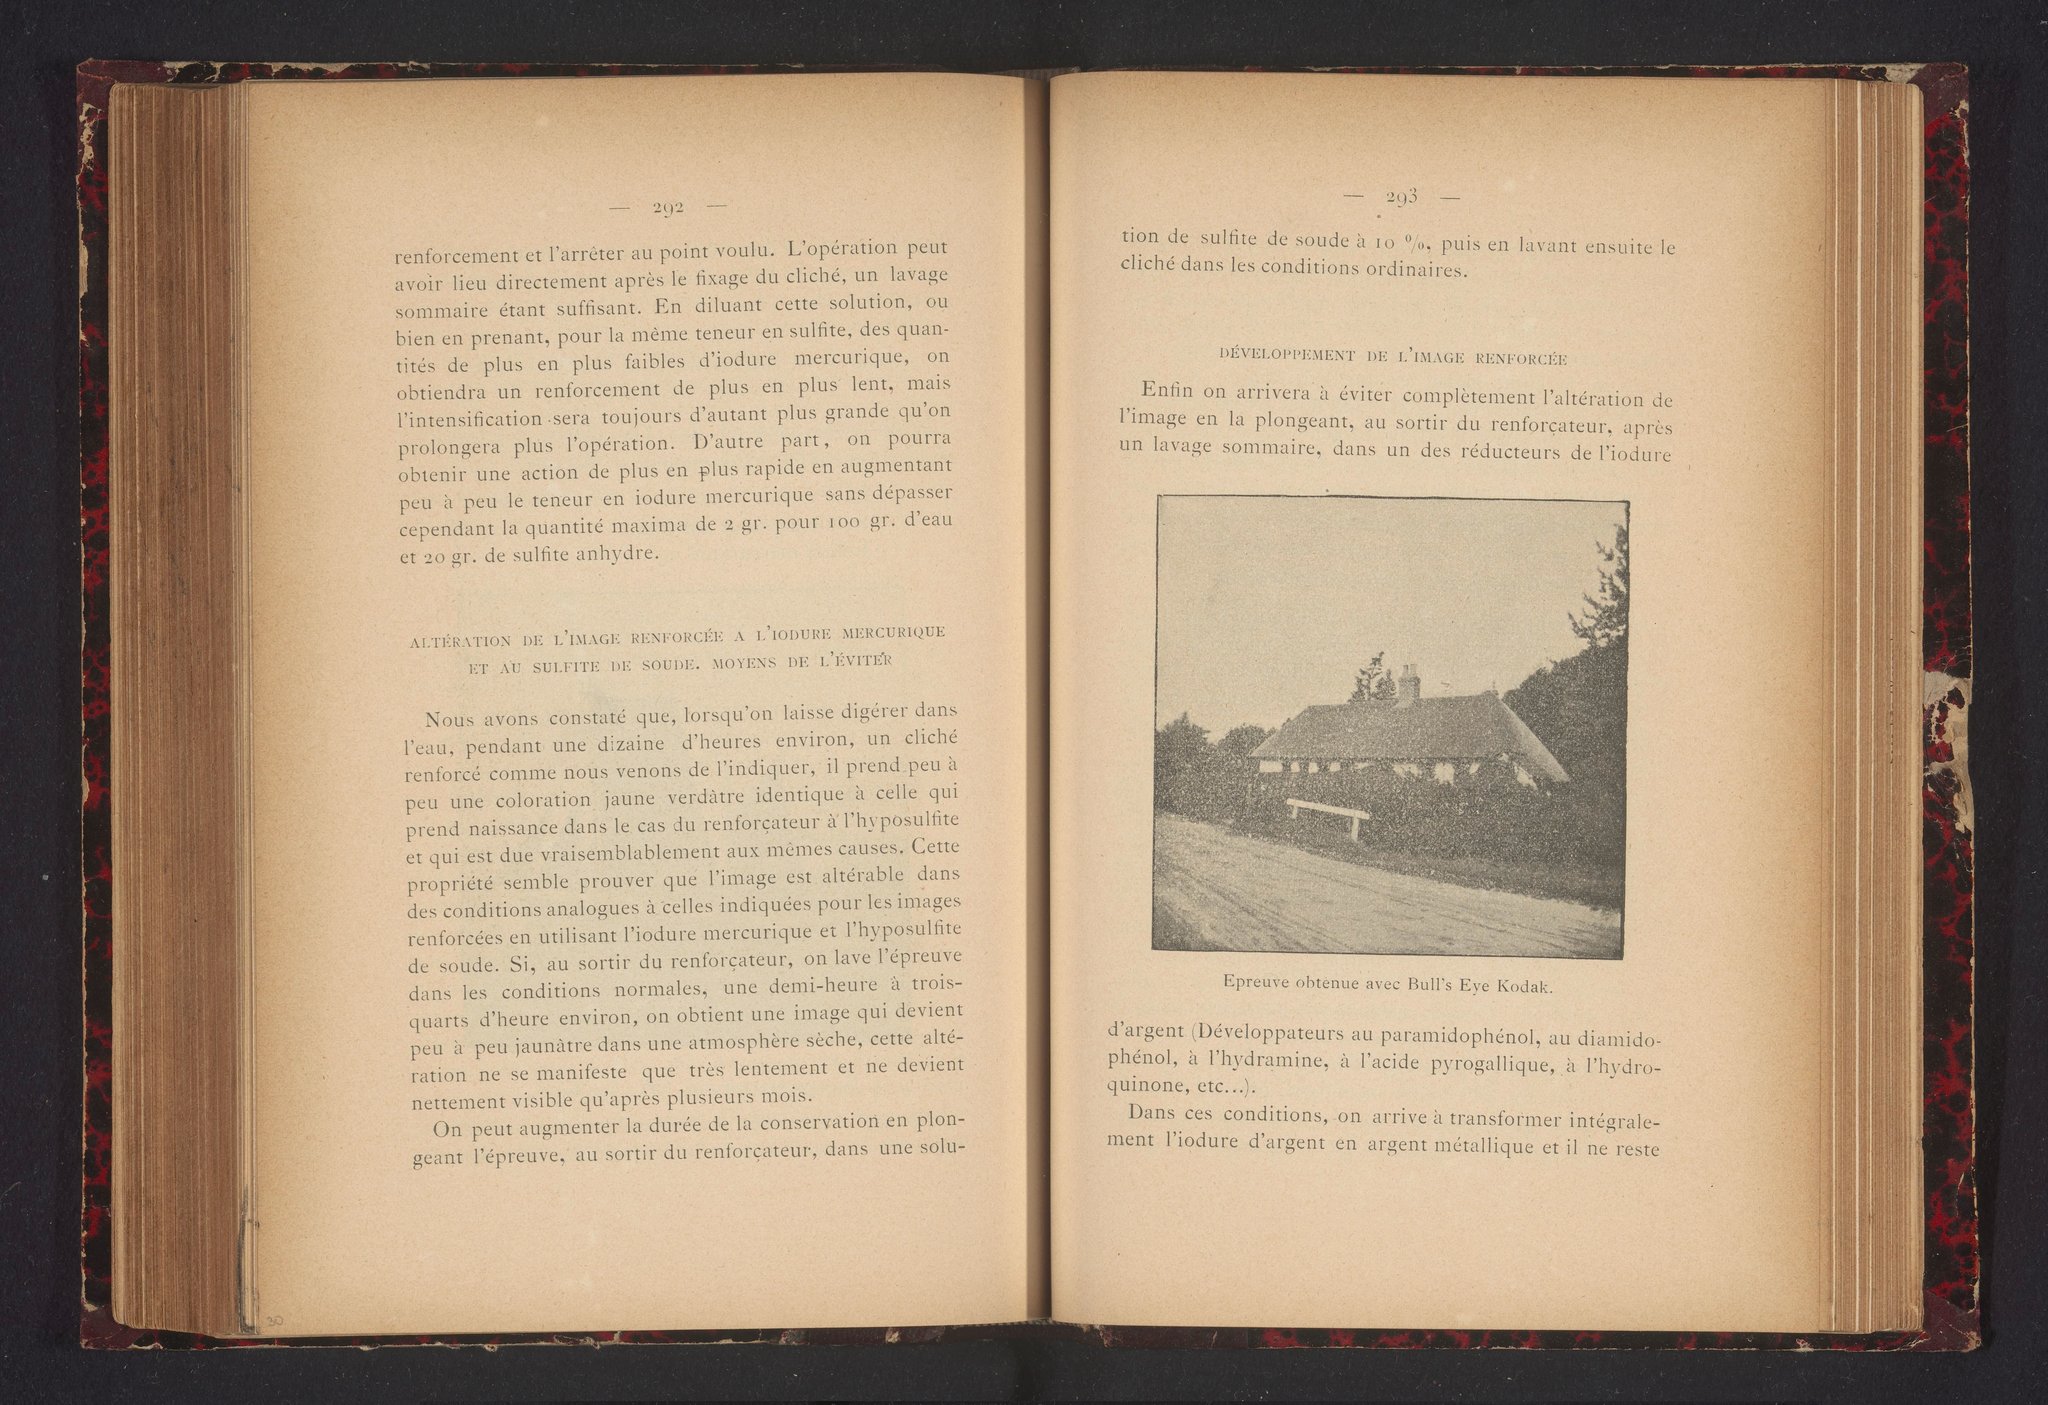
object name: photomechanical print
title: Epreuve obtenue avec Bull's Eye Kodak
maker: Anonymous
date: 1894-1899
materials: paper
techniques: autotype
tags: road, path, country-house